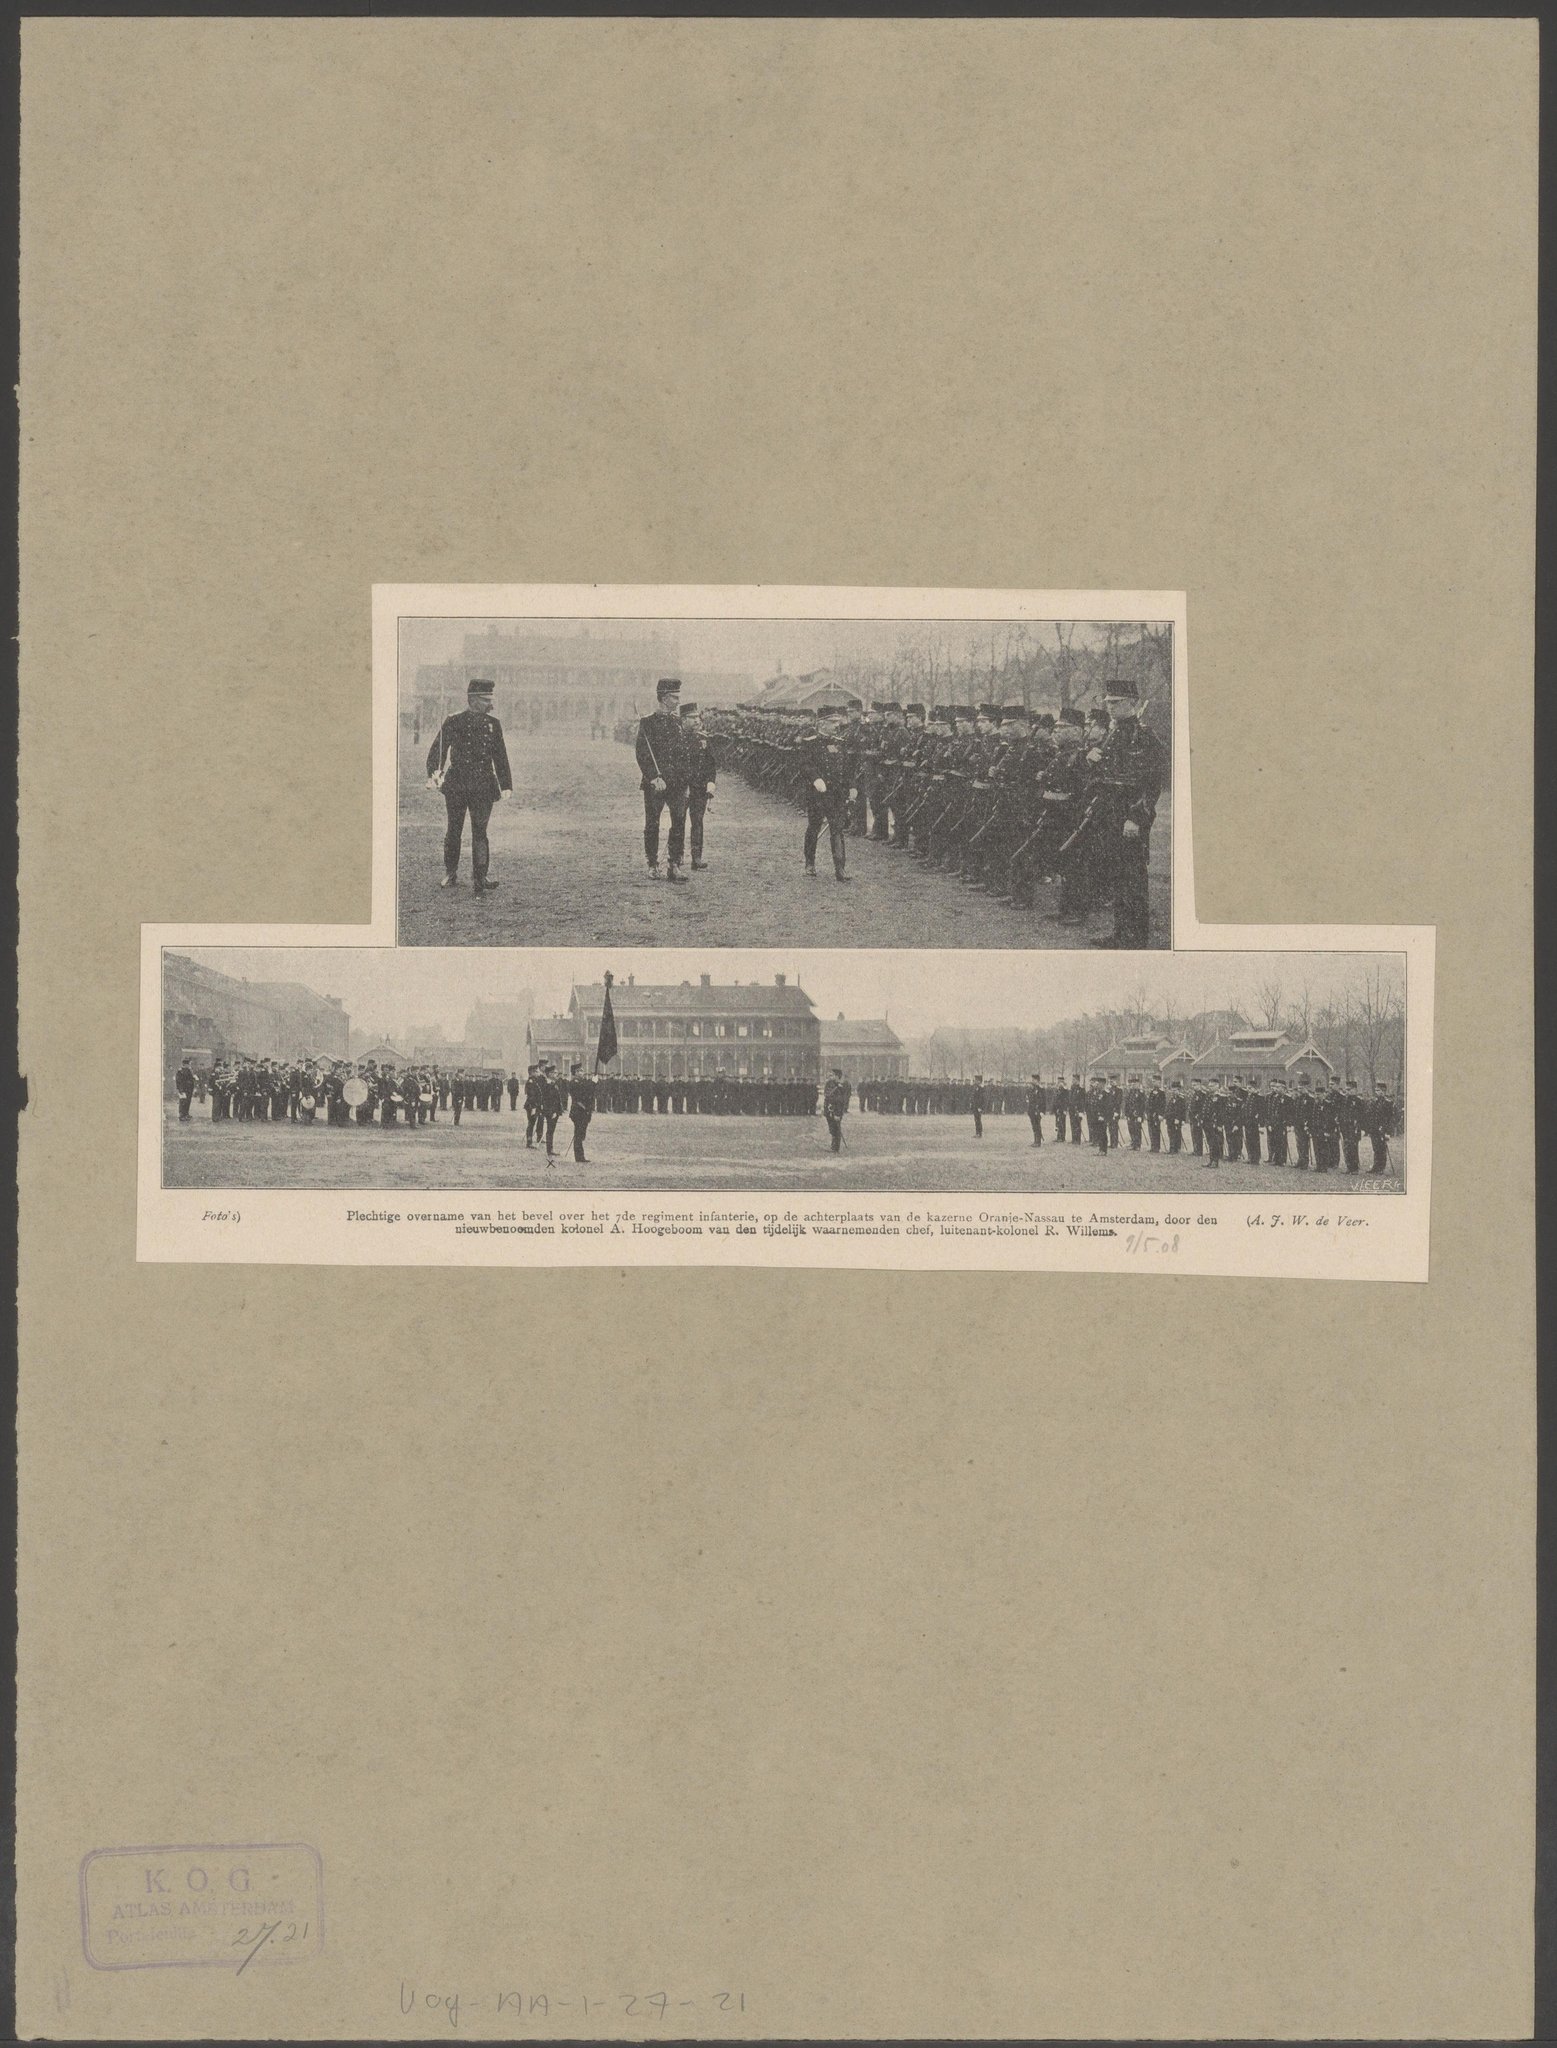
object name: photomechanical print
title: Schouwing van het 7e regiment Infanterie op het exercitieveld aan de Oranje-Nassau Kazerne te Amsterdam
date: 1908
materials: paper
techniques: letterpress printing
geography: amsterdam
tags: review, inspection (of company, unit, troop)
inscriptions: collector's mark: Lugt 1641b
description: Onderwerpsrubriek binnen de Atlas Amsterdam: Landmacht: Gebouwen / Herinneringen aan officieren, stadssoldaten / Nationale militie / (diverse korpsen) / Padvinders / Parade.